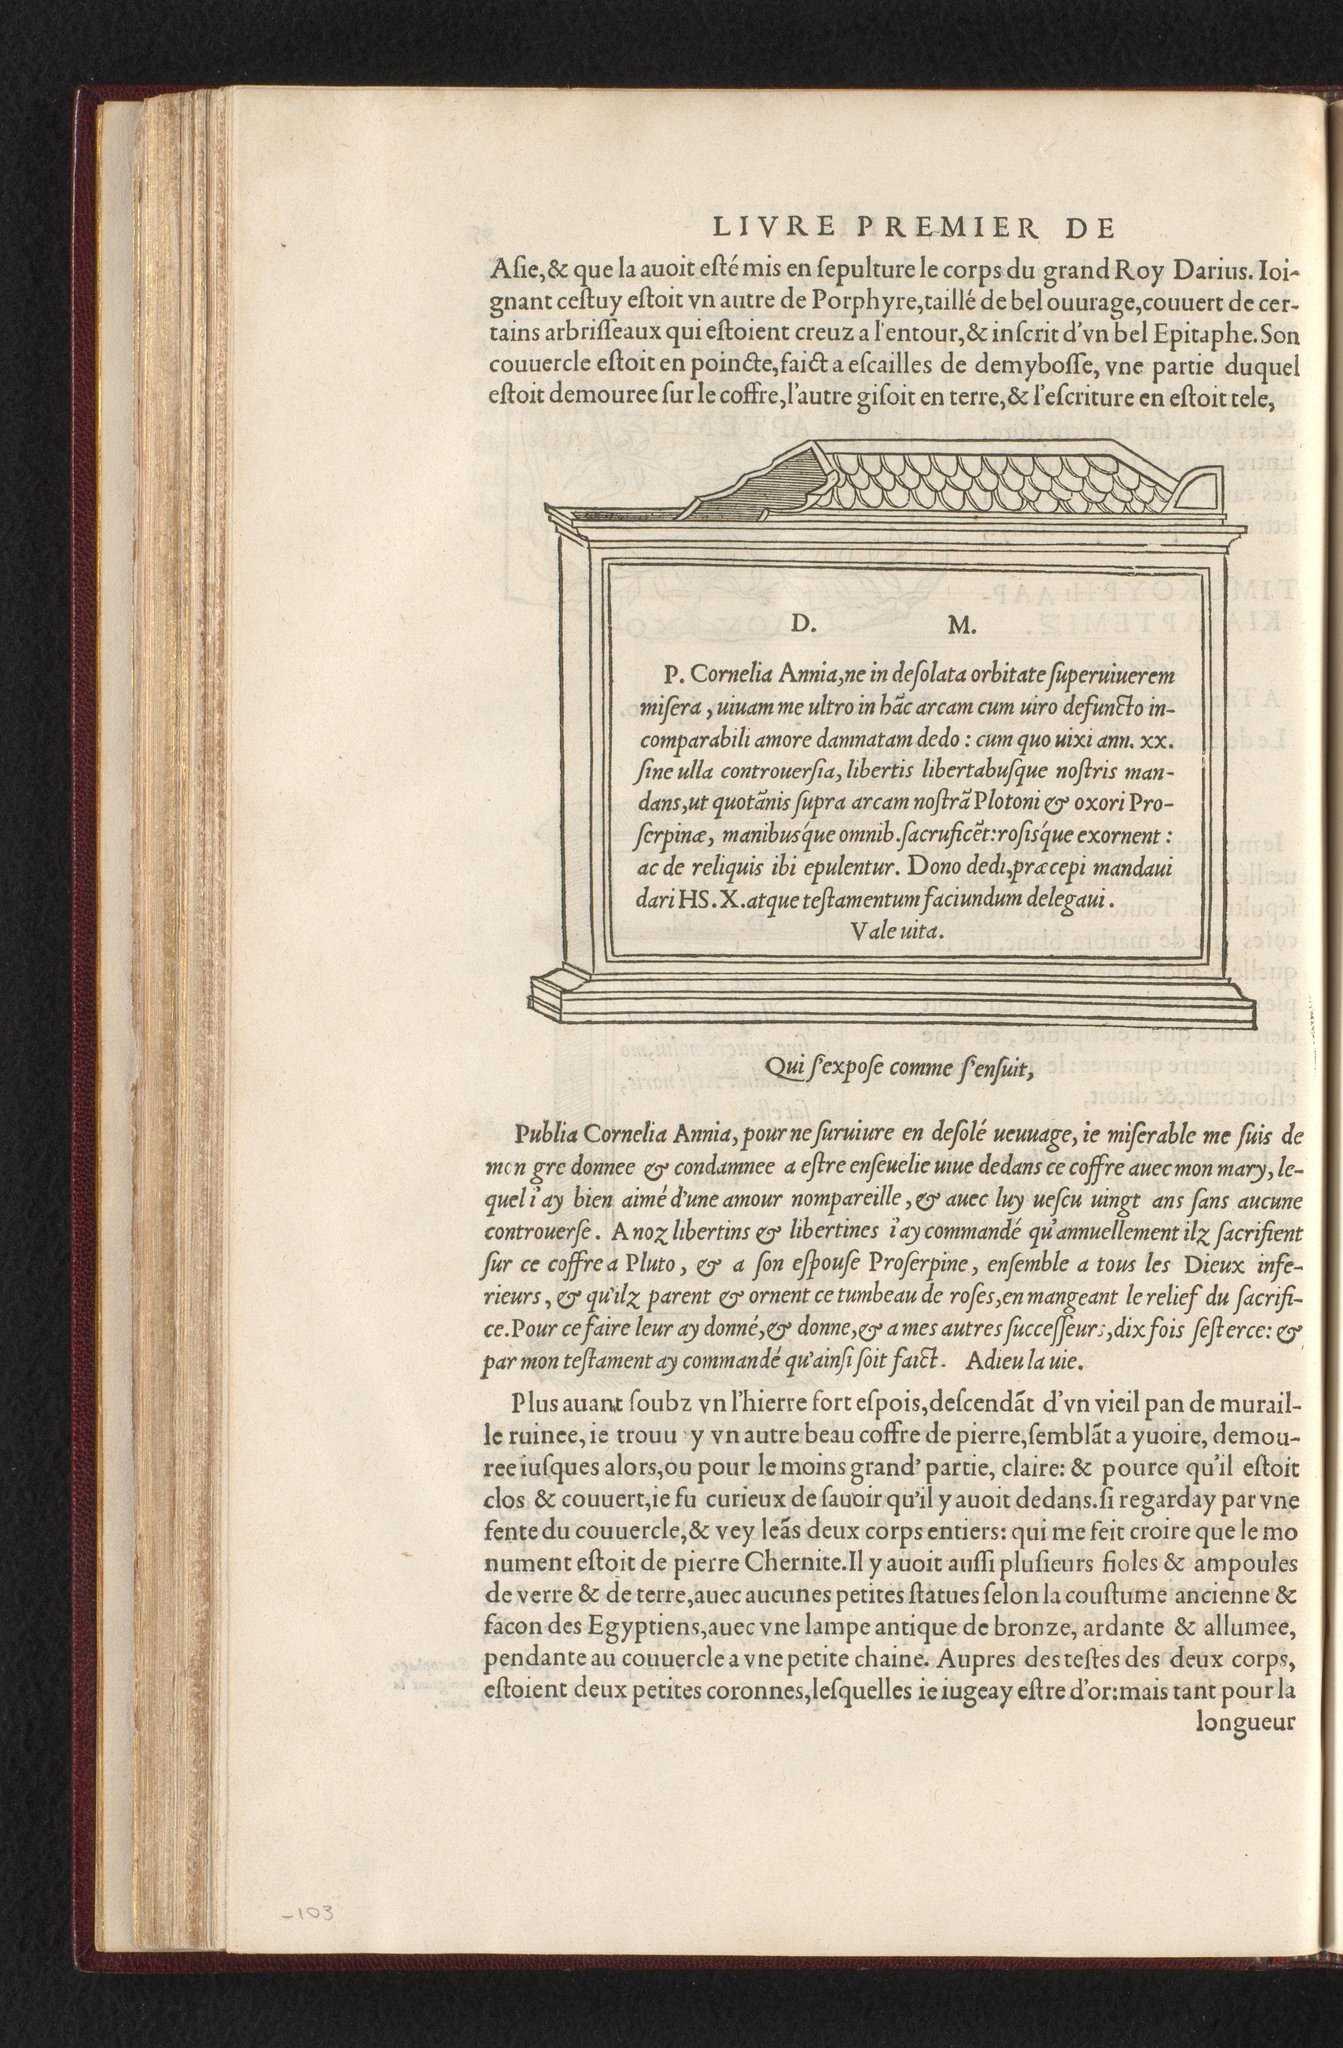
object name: book illustration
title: Sarcofaag met opschrift in het Latijn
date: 1546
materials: paper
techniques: letterpress printing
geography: paris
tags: inscription, (scenes from) specific works of literature: colonna, hypnerotomachia poliphili, sarcophagus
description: Prent uit: Colonna, Francesco. Hypnerotomachie ou discours du songe de Poliphile, deduisant comme amour le combat a l'occasion de Polia. Parijs: Jacques Kerver, 1546, verso fol. 95.